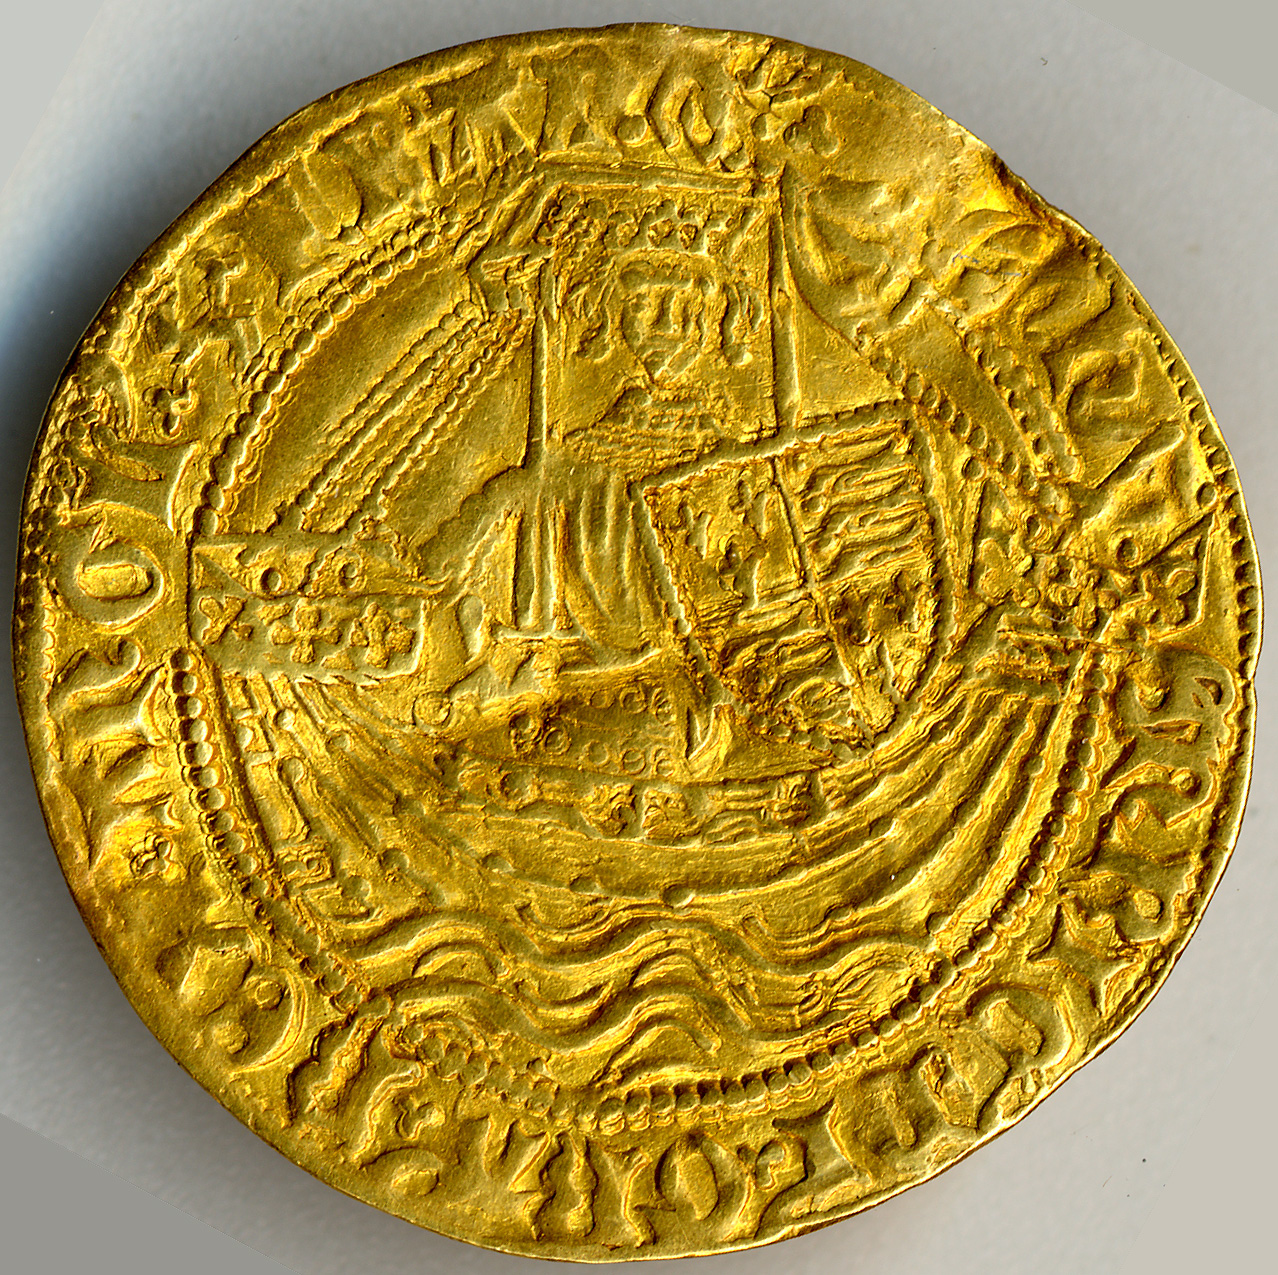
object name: coin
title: Quarter Noble of Edward III (r. 1327–77)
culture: british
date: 1327-1377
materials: gold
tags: kings,coat of arms